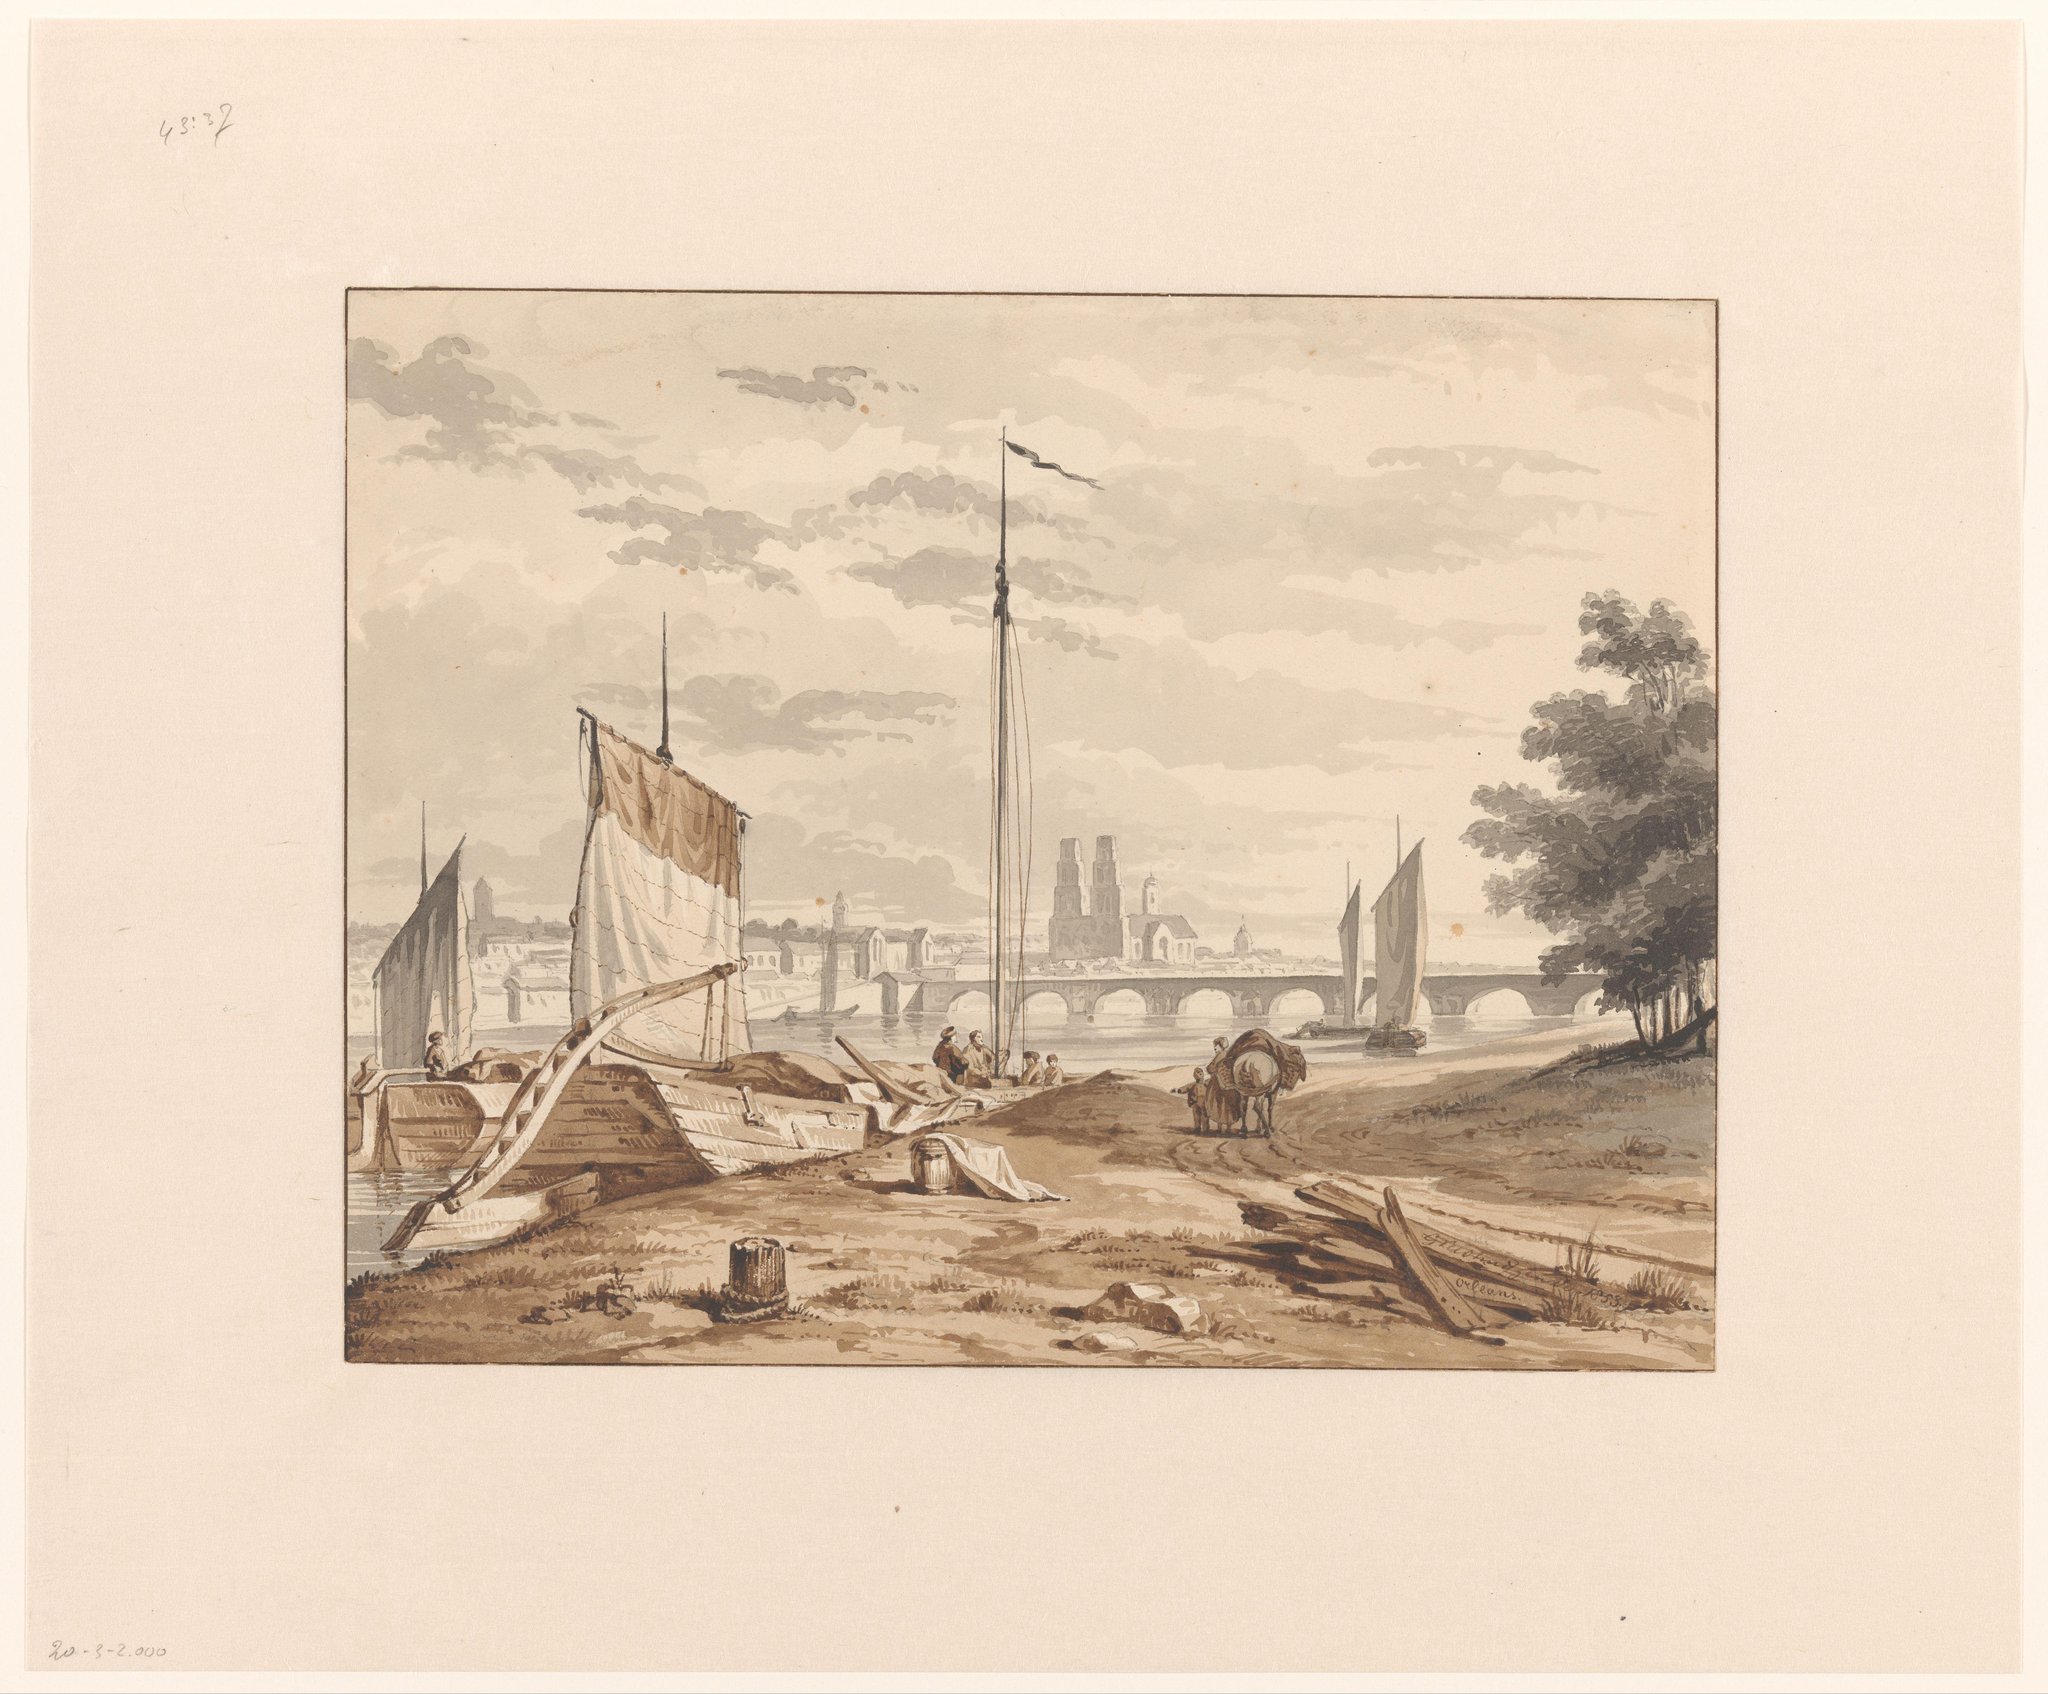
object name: drawing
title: Gezicht op Orléans van de overzijde van de Loire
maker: g. veldhuyzen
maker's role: draughtsman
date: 1853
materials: ink, paper, pencil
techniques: brush, pen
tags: prospect of city, town panorama, silhouette of city, france